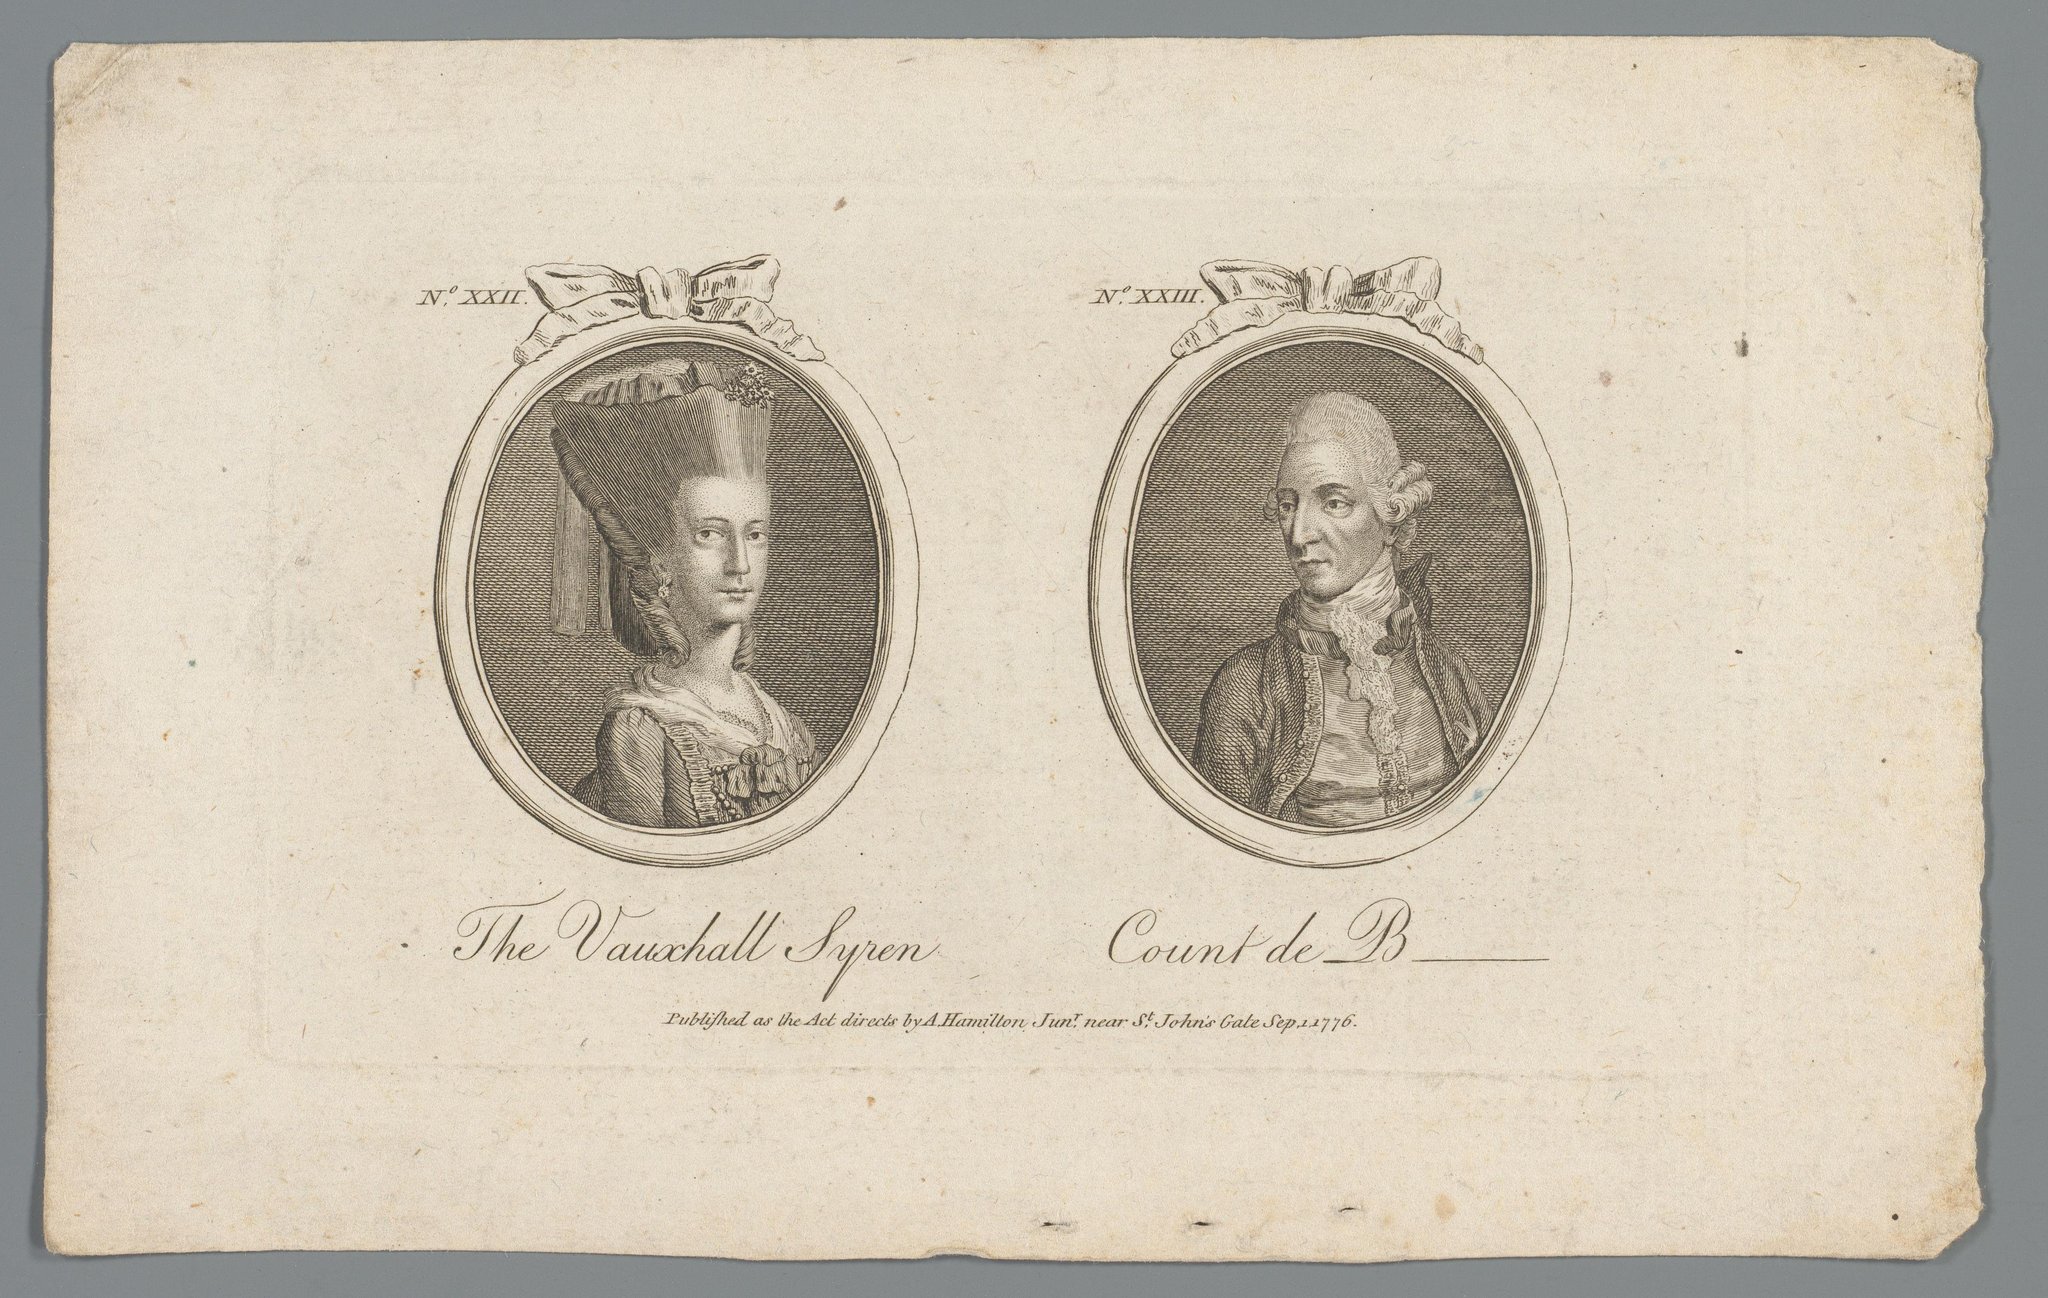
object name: print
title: Portret van Charlotte Brent en Ludovico di Belgiojoso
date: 1776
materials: paper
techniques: etching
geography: london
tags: vienna, earl, historical persons - bb - woman, historical persons, portrait of opera-singer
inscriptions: collector's mark: Lugt 2228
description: Prent waarschijnlijk uit: Town and Country Magazine 8 (1776), september 1776.